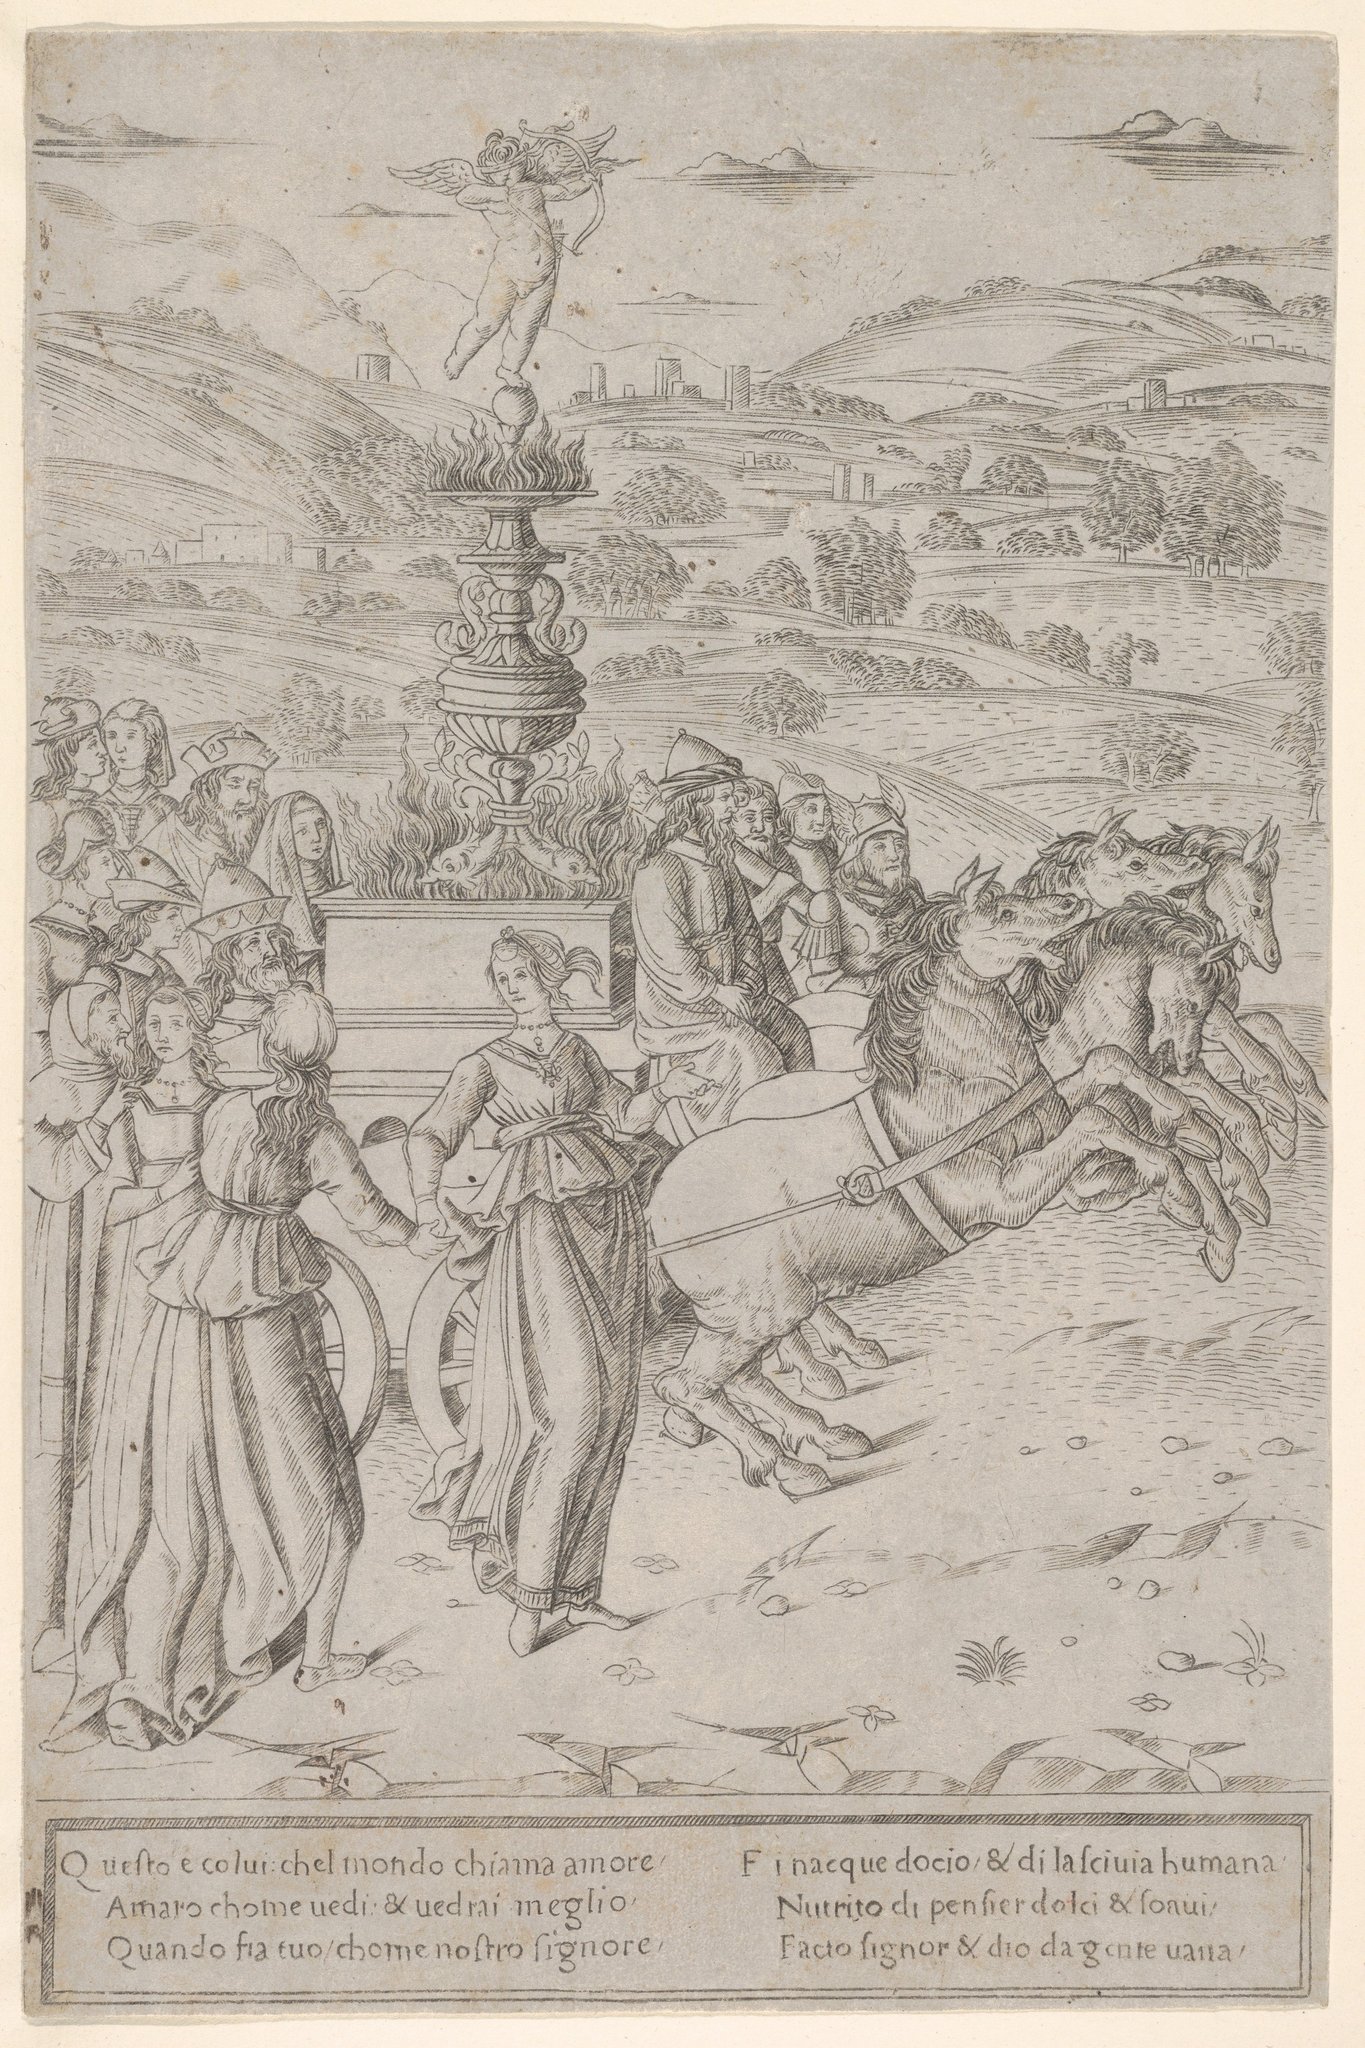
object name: print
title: The Triumph of Love, from "The Triumphs of Petrarch"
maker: francesco rosselli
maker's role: artist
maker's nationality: italian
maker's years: 1448-1527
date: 1480-1500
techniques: engraving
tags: men,women,cupid,horses